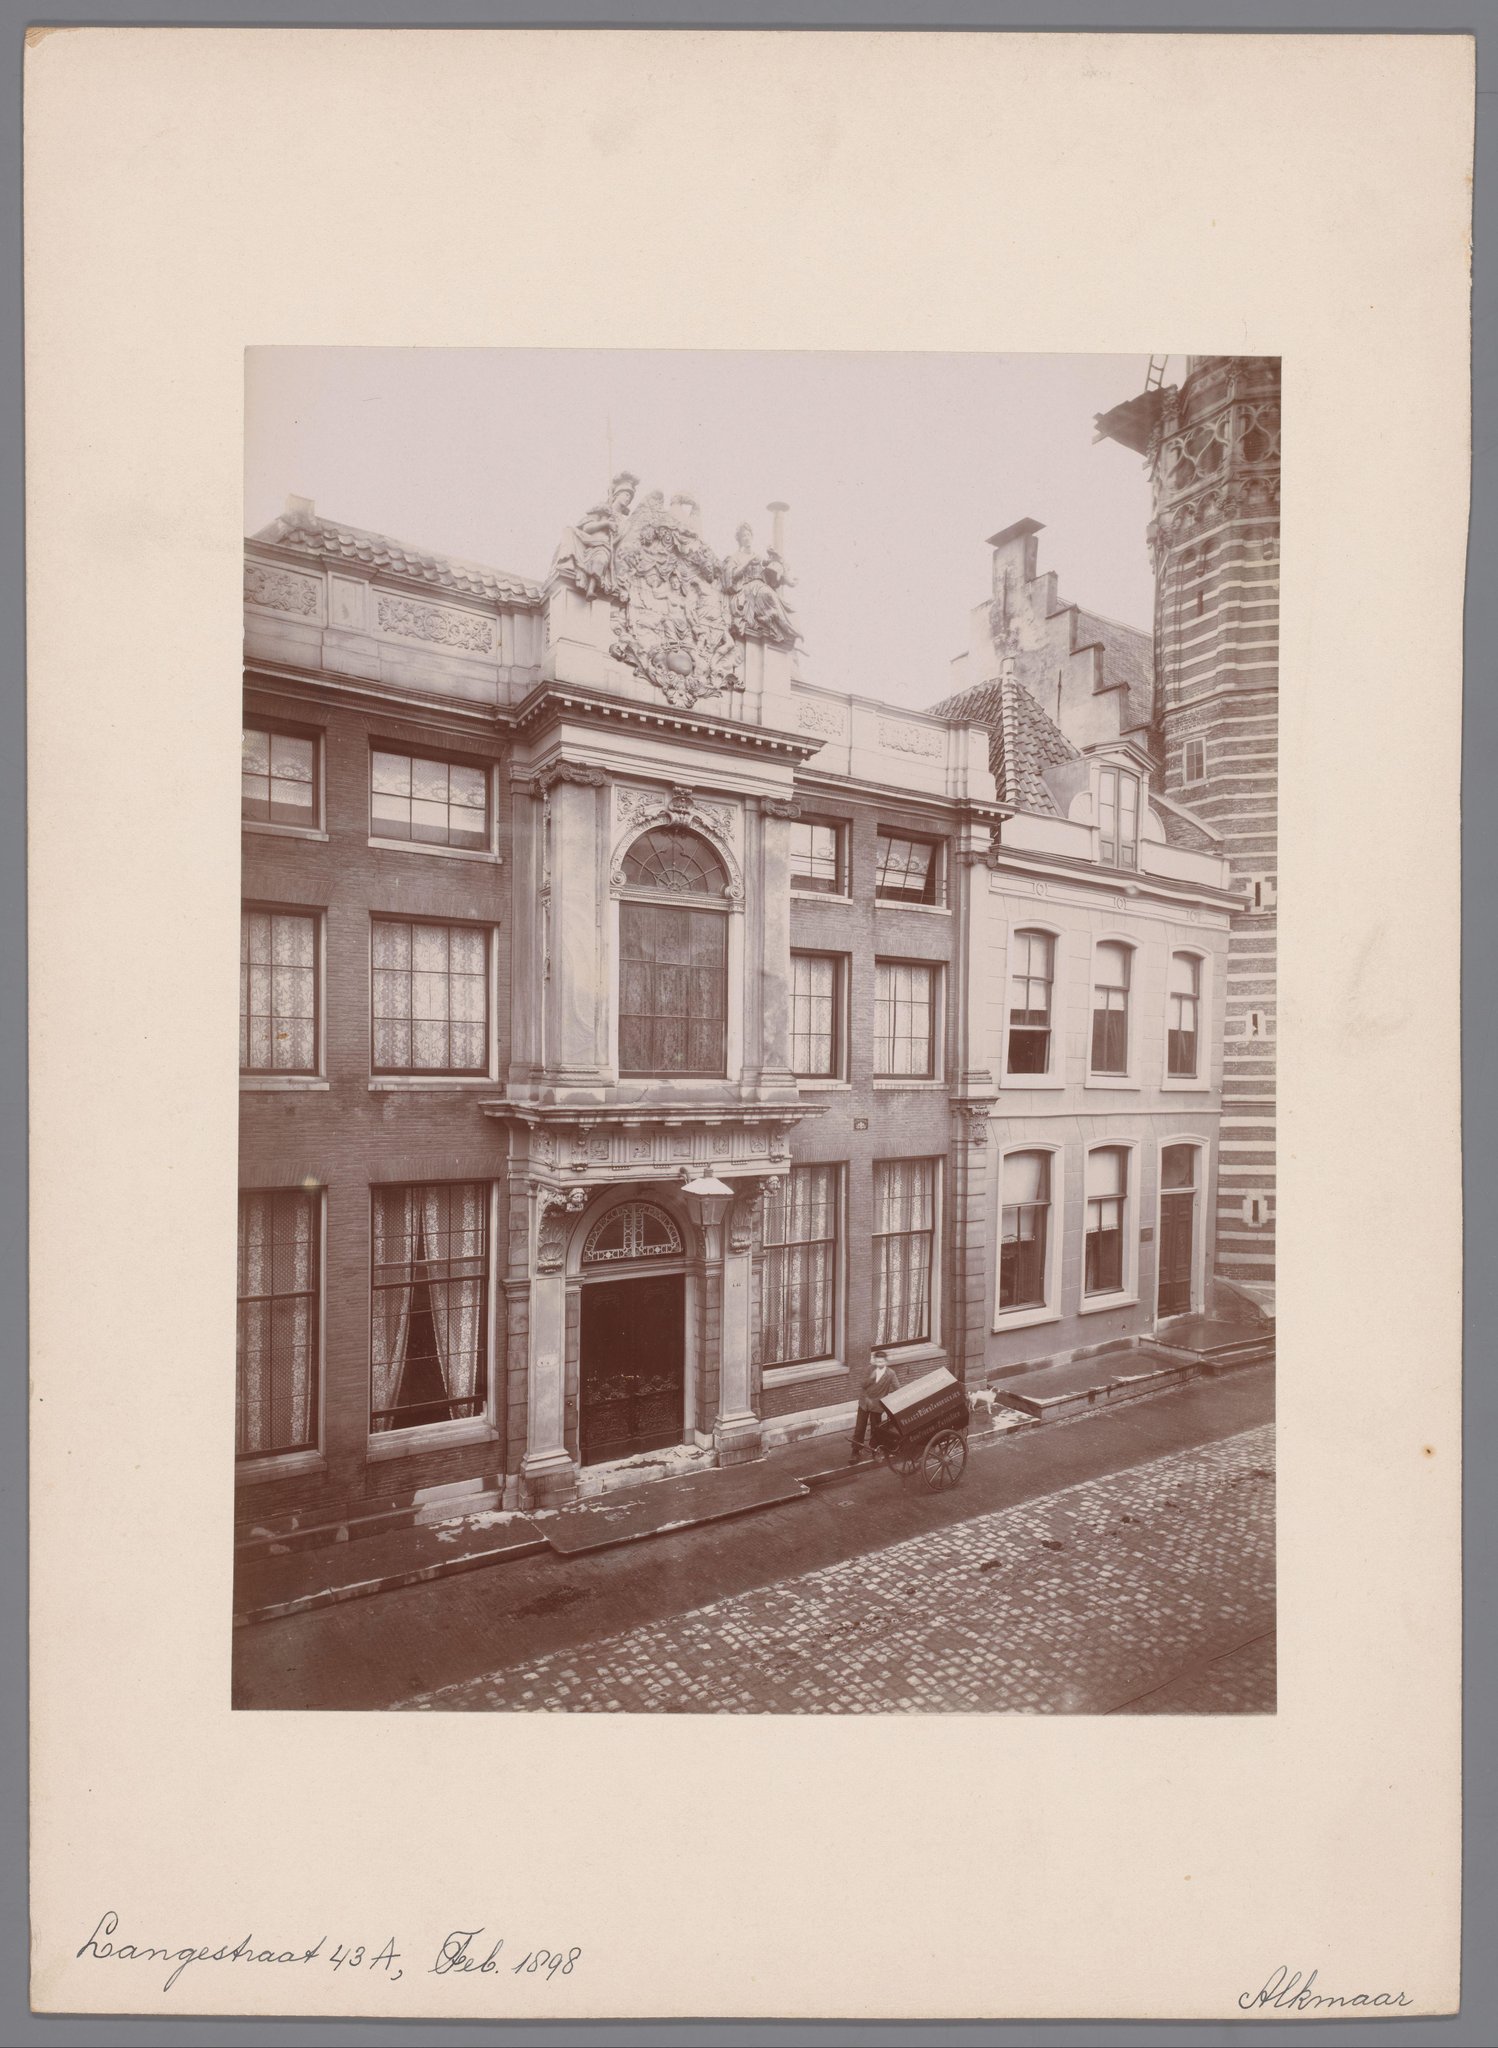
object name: photograph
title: Gezicht op Langestraat 43A te Alkmaar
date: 1898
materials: cardboard, photographic support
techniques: gelatin silver print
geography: langestraat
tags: urban housing, façade (of house or building)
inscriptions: annotation: ‘Langestraat 43A, Feb. 1898/ Alkmaar’, annotation: ‘Alkmaar/ Huis A No. 43 Langestraat/ feb 1898’